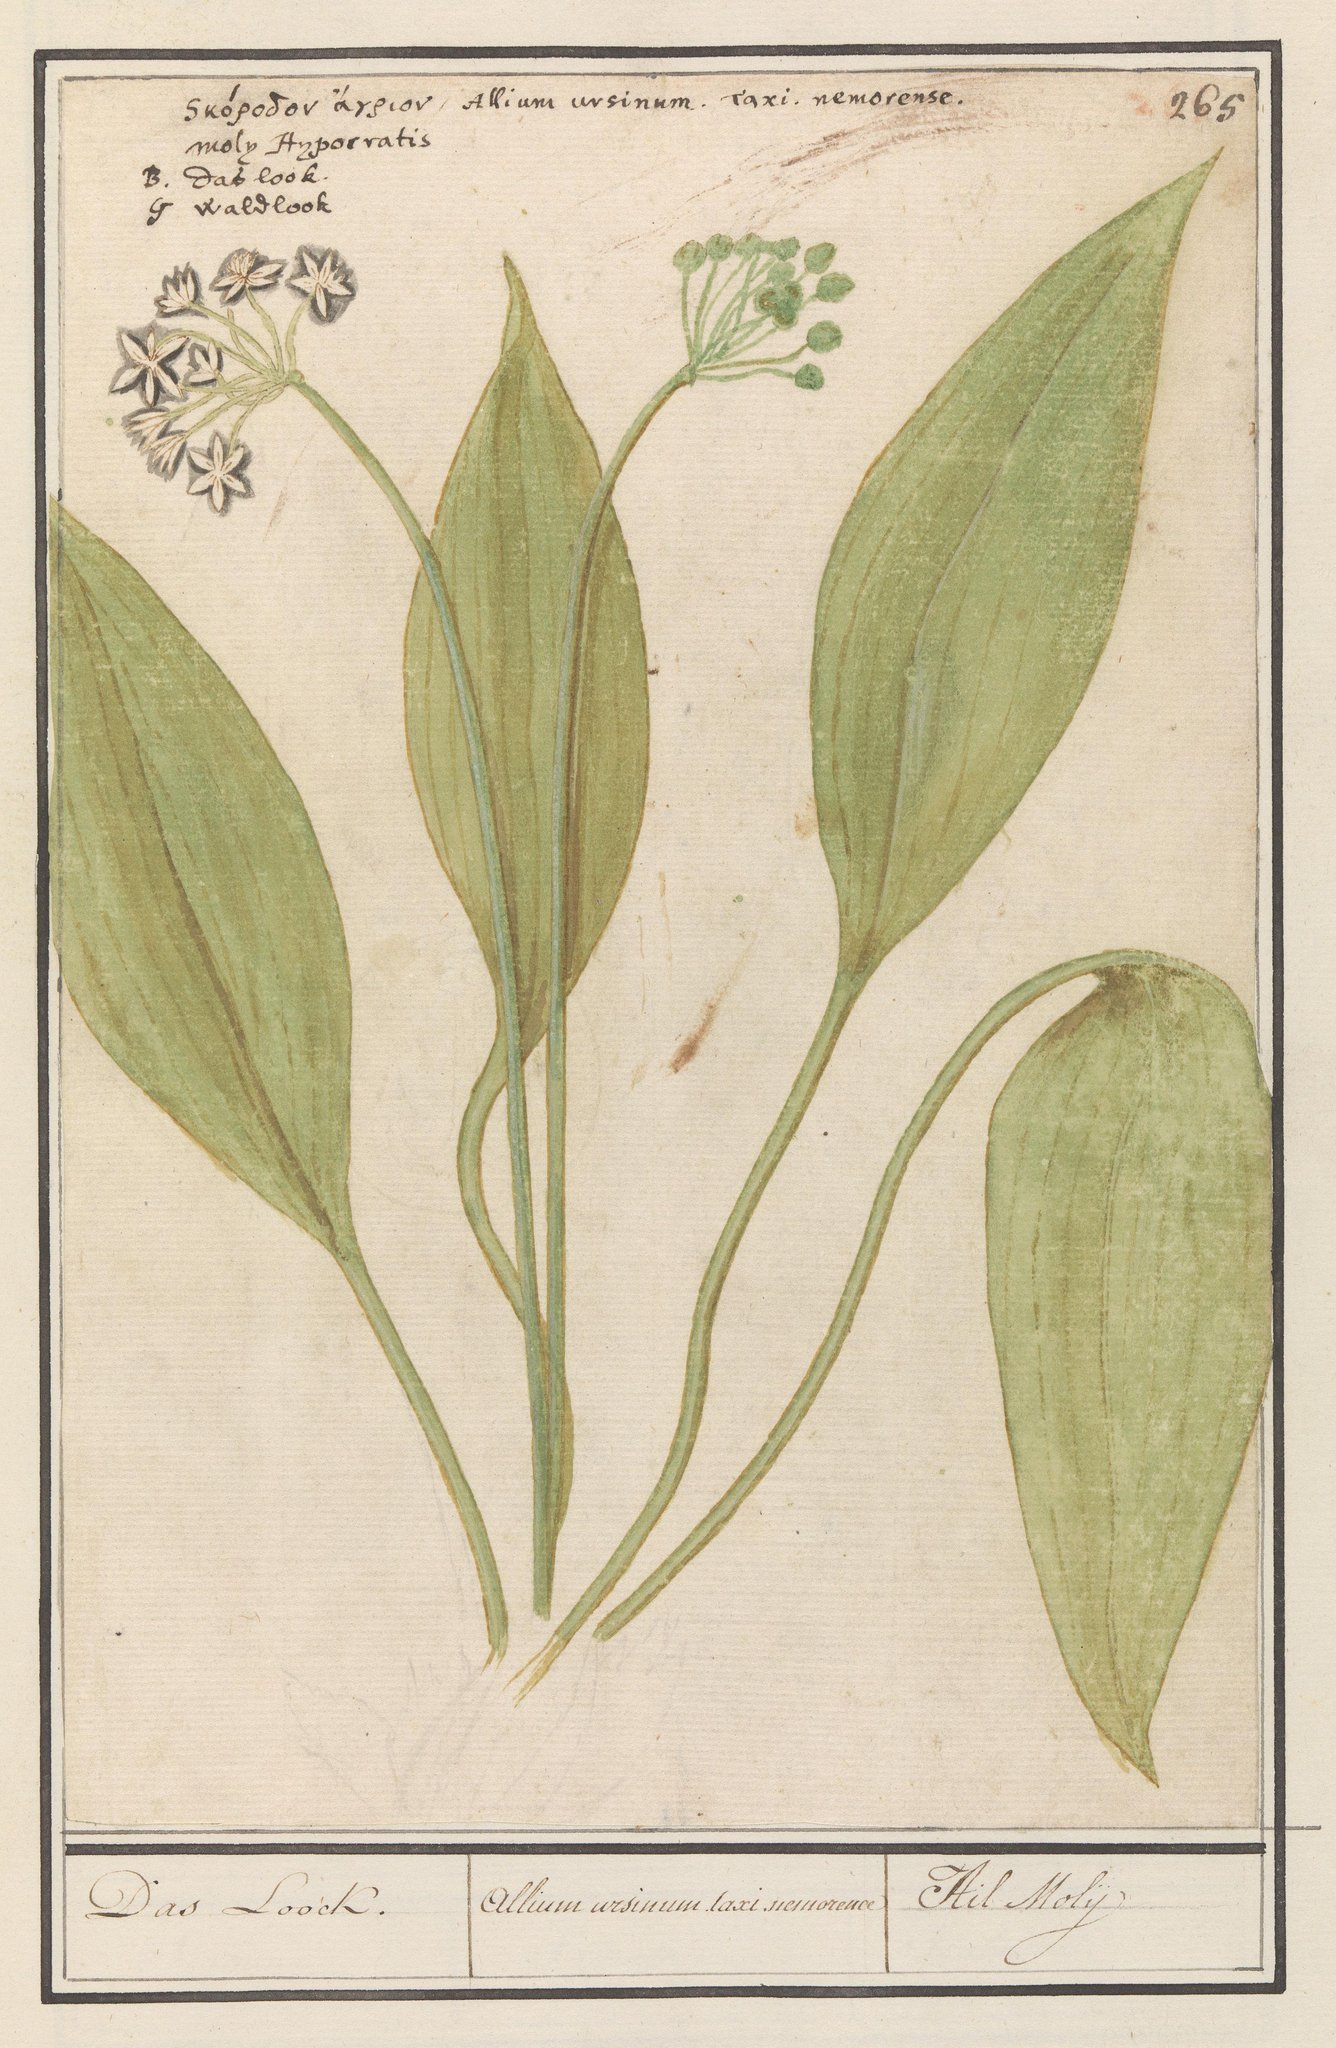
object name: drawing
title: Daslook (Allium ursinum)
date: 1596-1610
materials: chalk, paint, ink, paper, watercolor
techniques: brush, pen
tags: flowers: ramsoms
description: Daslook. Genummerd rechtsboven: 265. Linksbovenaan de naam in drie talen. Onderdeel van het derde album met tekeningen van bloemen en planten. Tiende van twaalf albums met tekeningen van dieren, vogels en planten bekend rond 1600, gemaakt in opdracht van keizer Rudolf II. Met toelichting in Nederlands, Latijn en Frans.